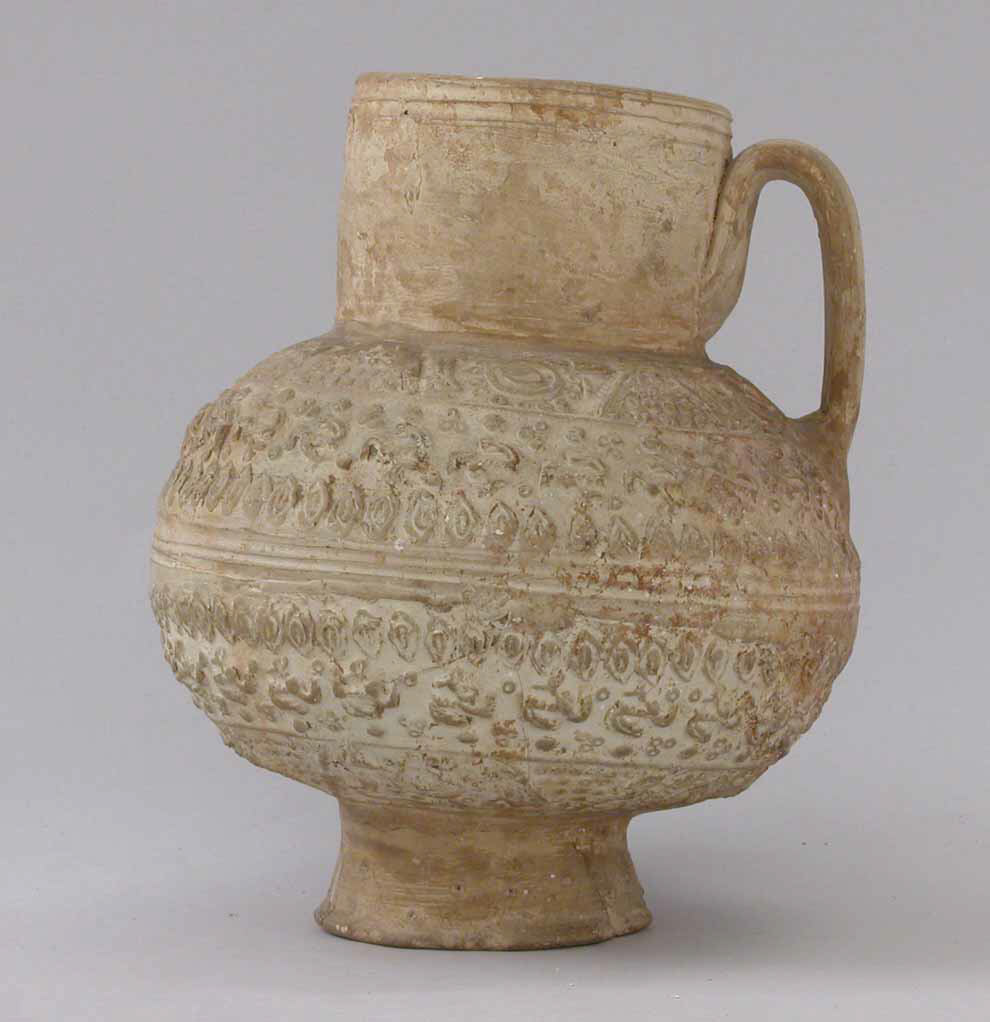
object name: ewer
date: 1101-1200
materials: earthenware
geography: syria